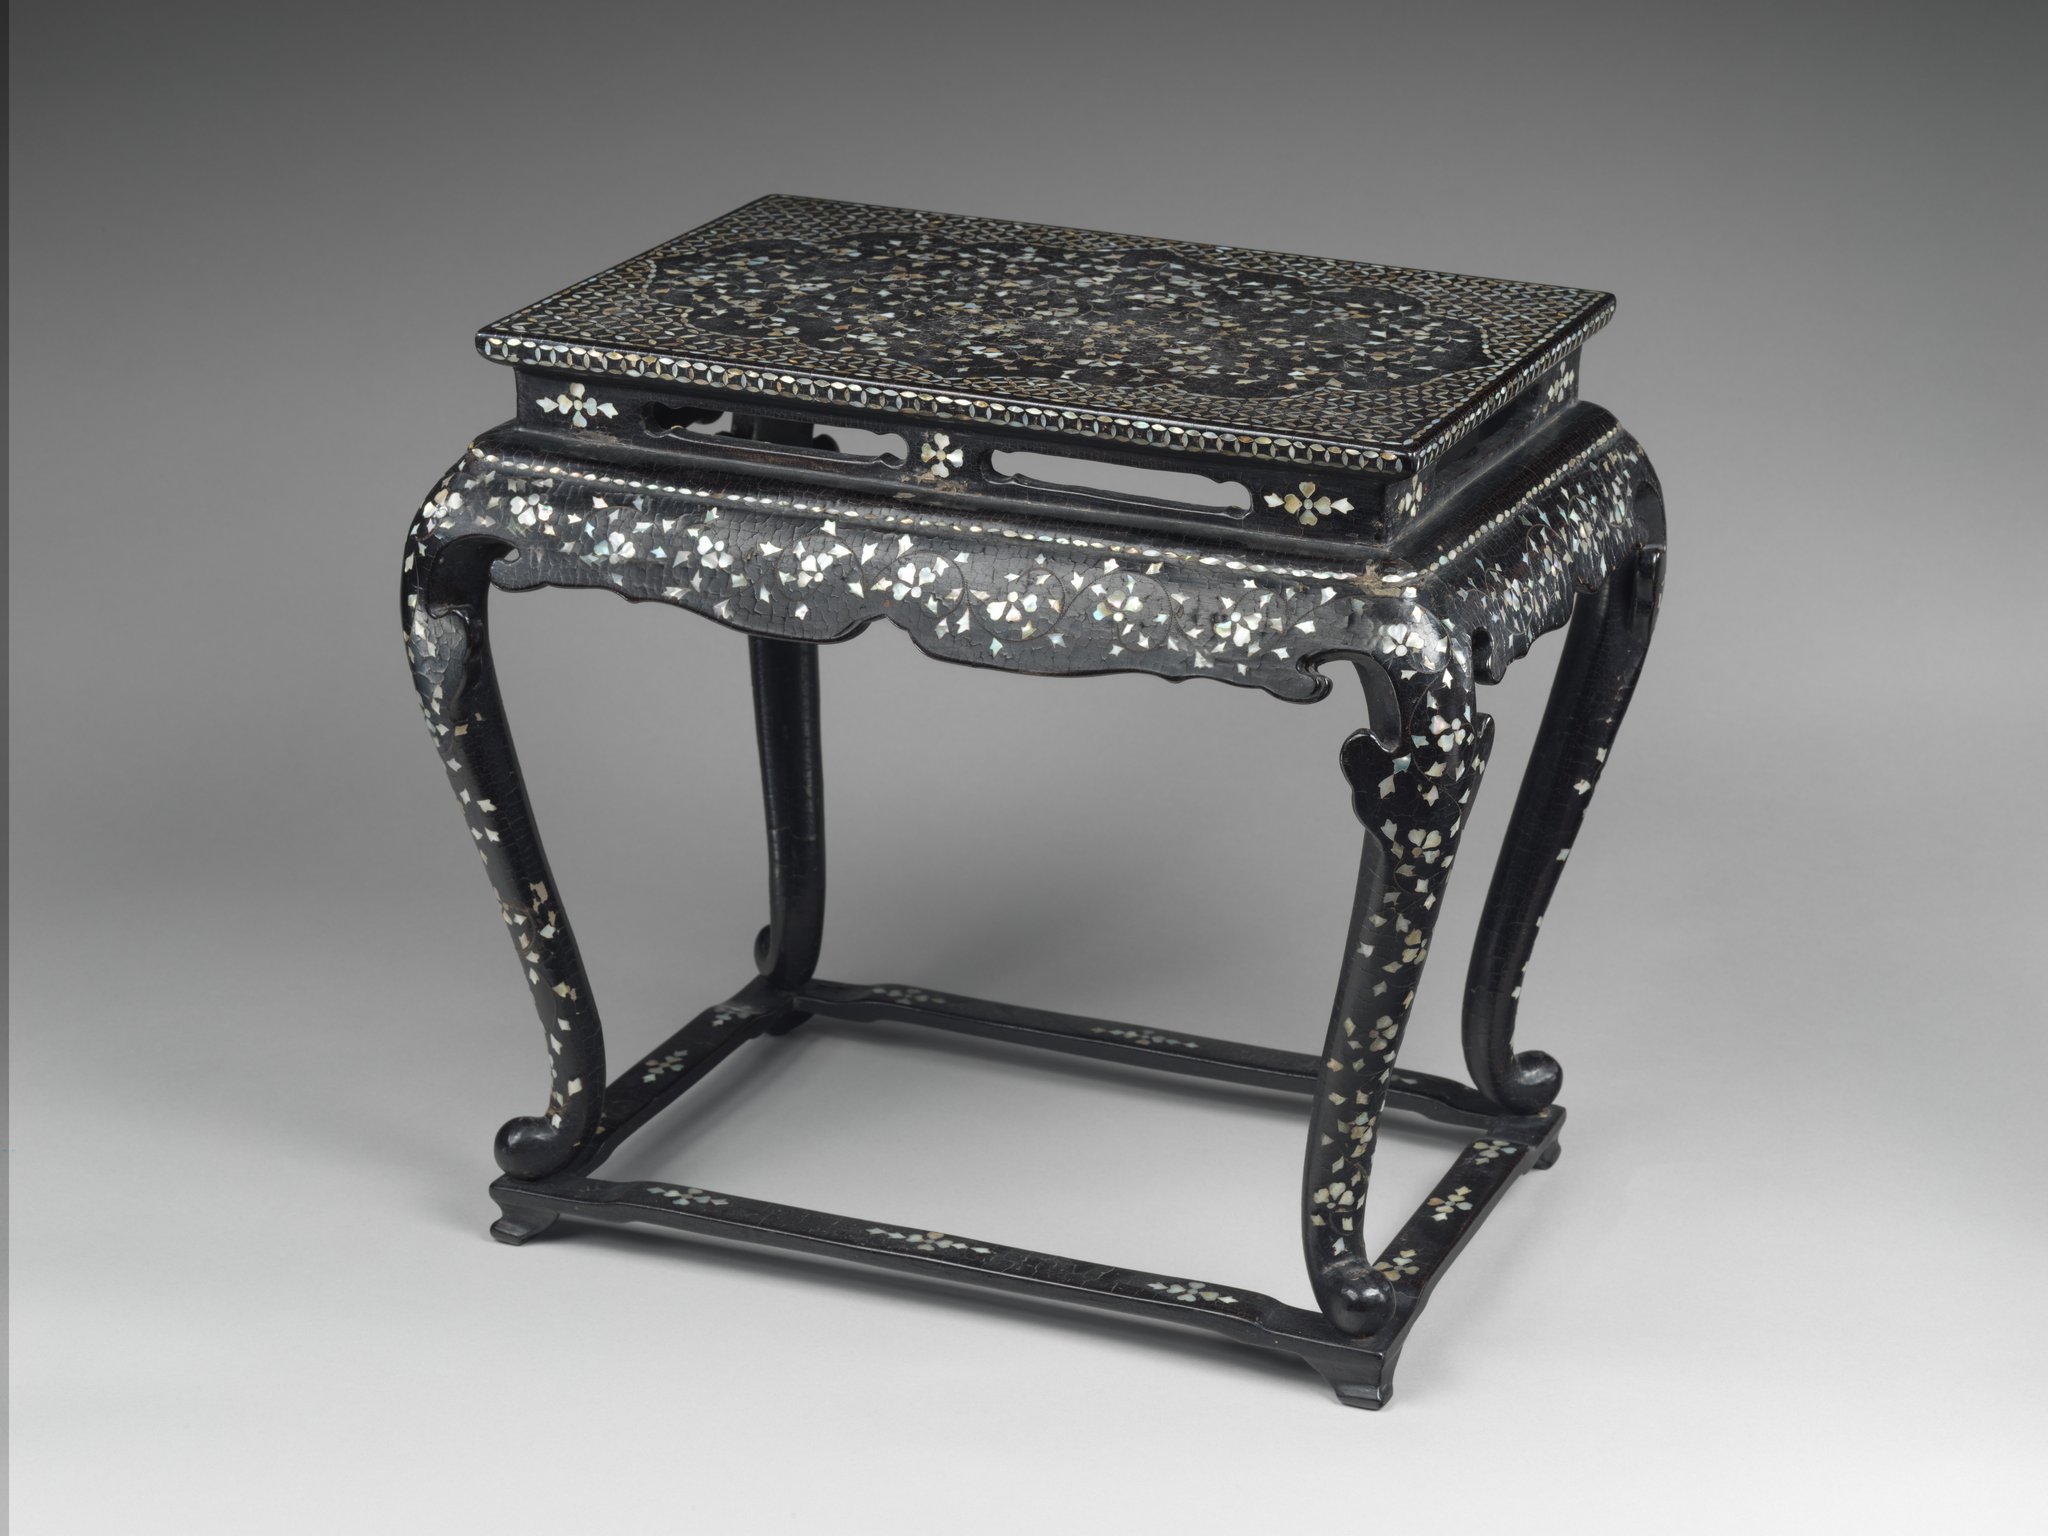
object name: table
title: Table decorated with floral scroll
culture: korean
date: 1801-1900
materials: lacquer, metal, mother of pearl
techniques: inlay